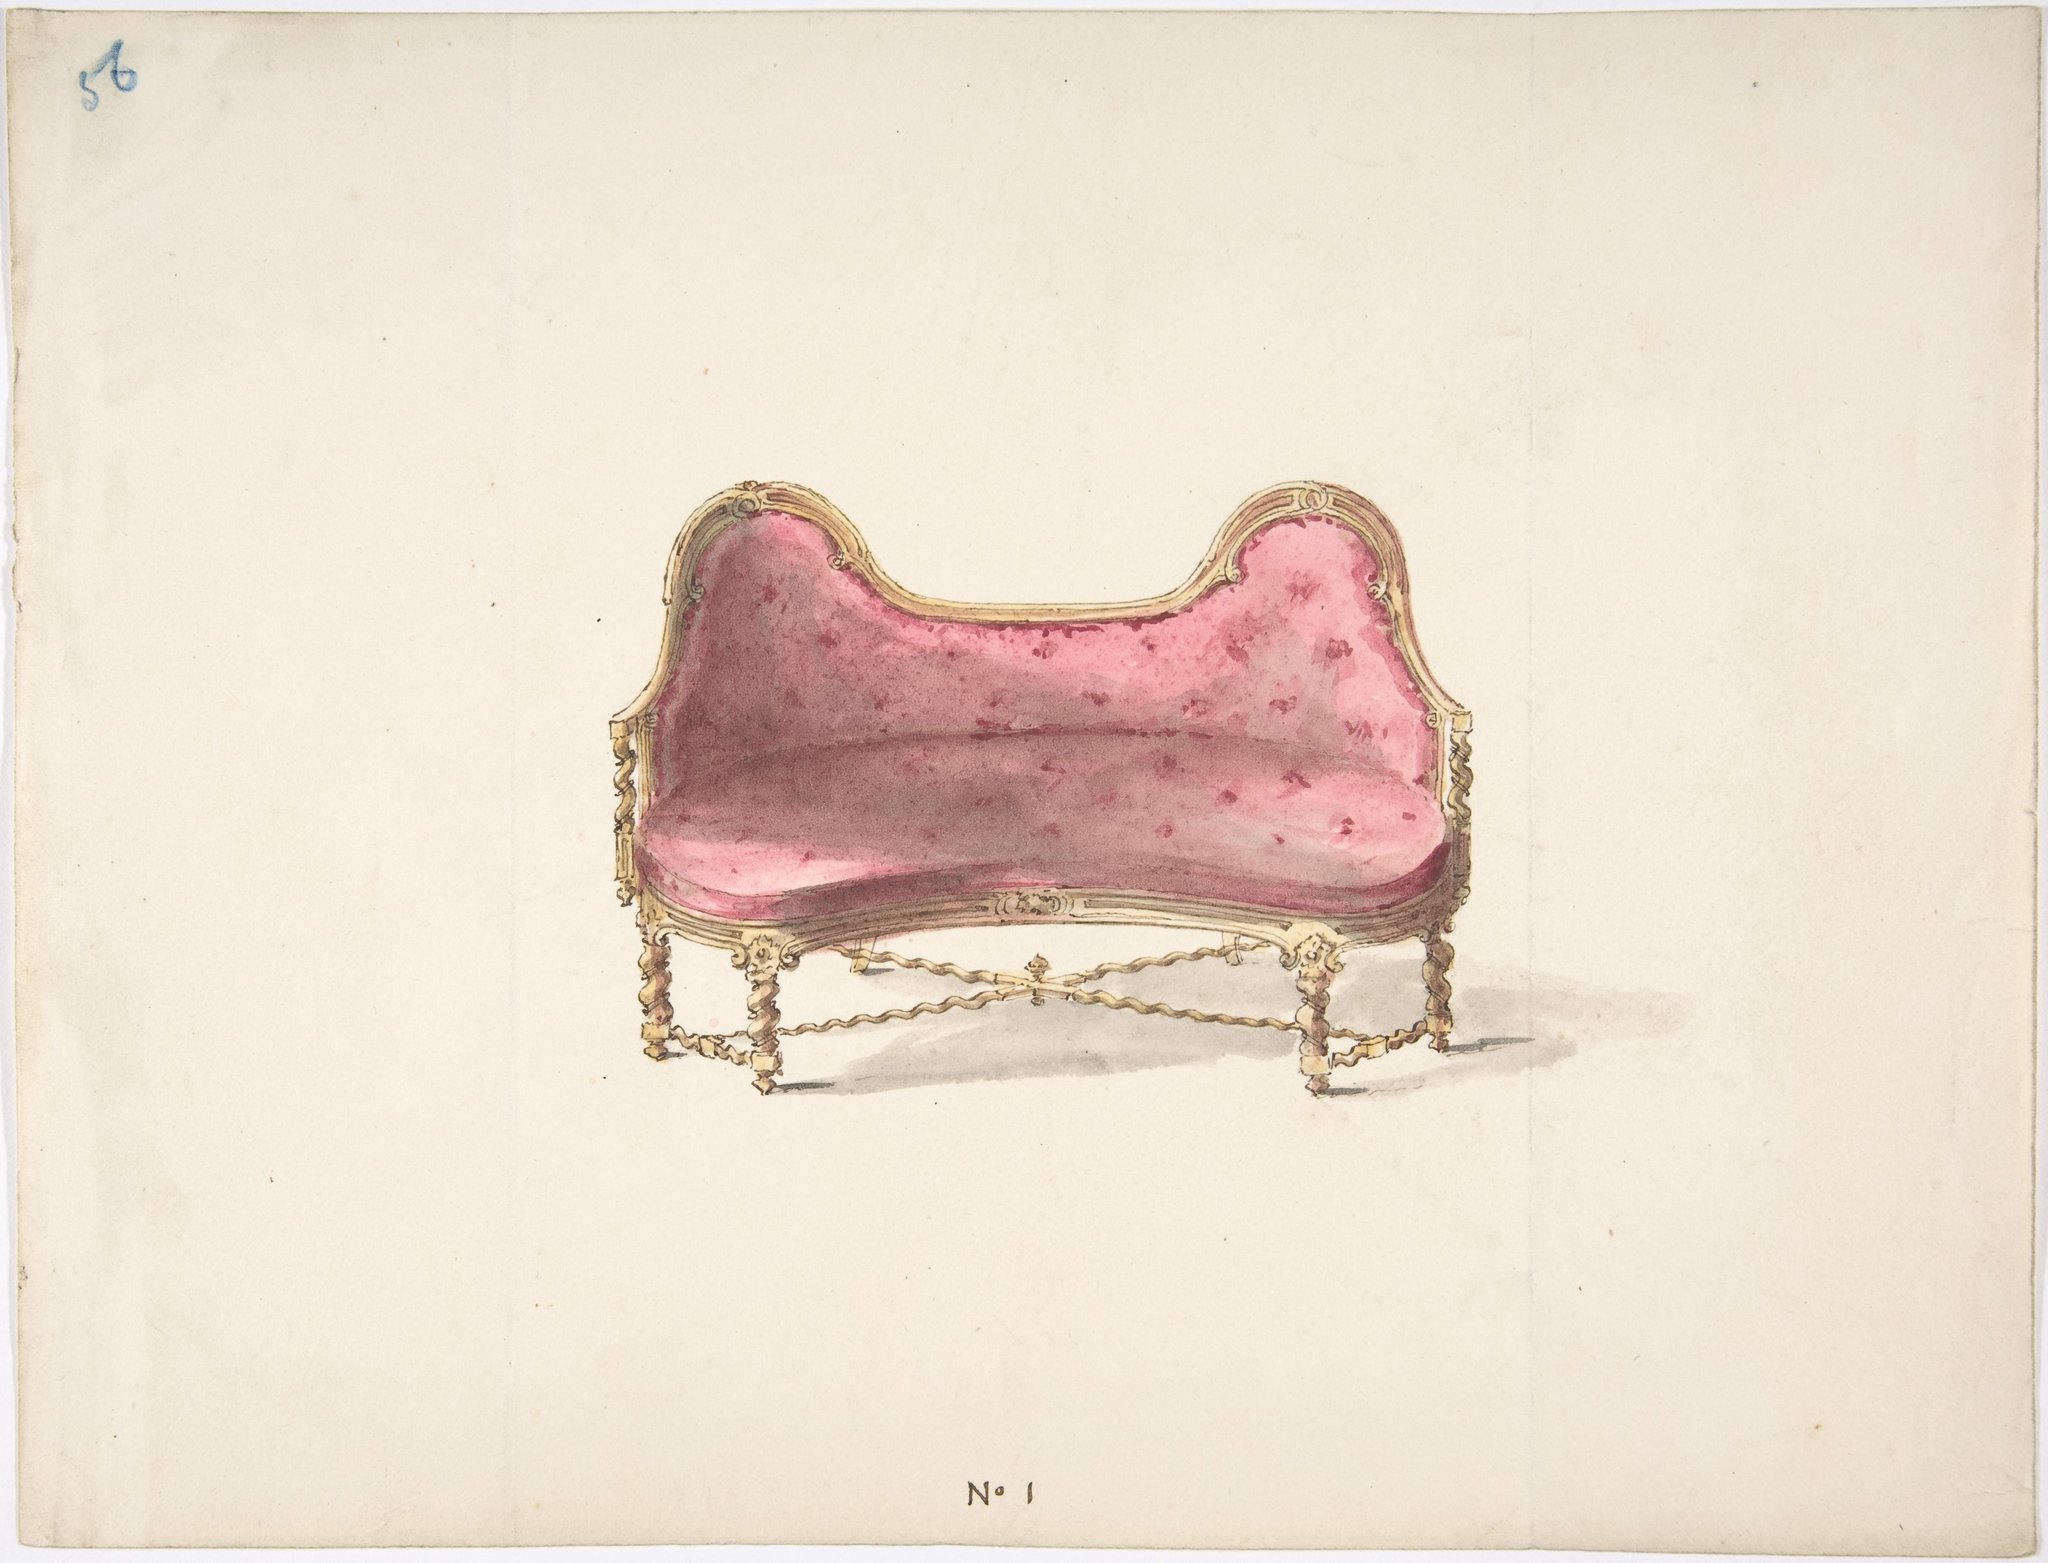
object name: drawing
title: Design for a Double Hump-backed Sofa with Turned Legs and Arms, with Red Tufted Upholstery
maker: anonymous, british, 19th century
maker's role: artist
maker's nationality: british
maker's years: 1800-1900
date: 1801-1833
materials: ink, watercolor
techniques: brush, pen, wash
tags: couches